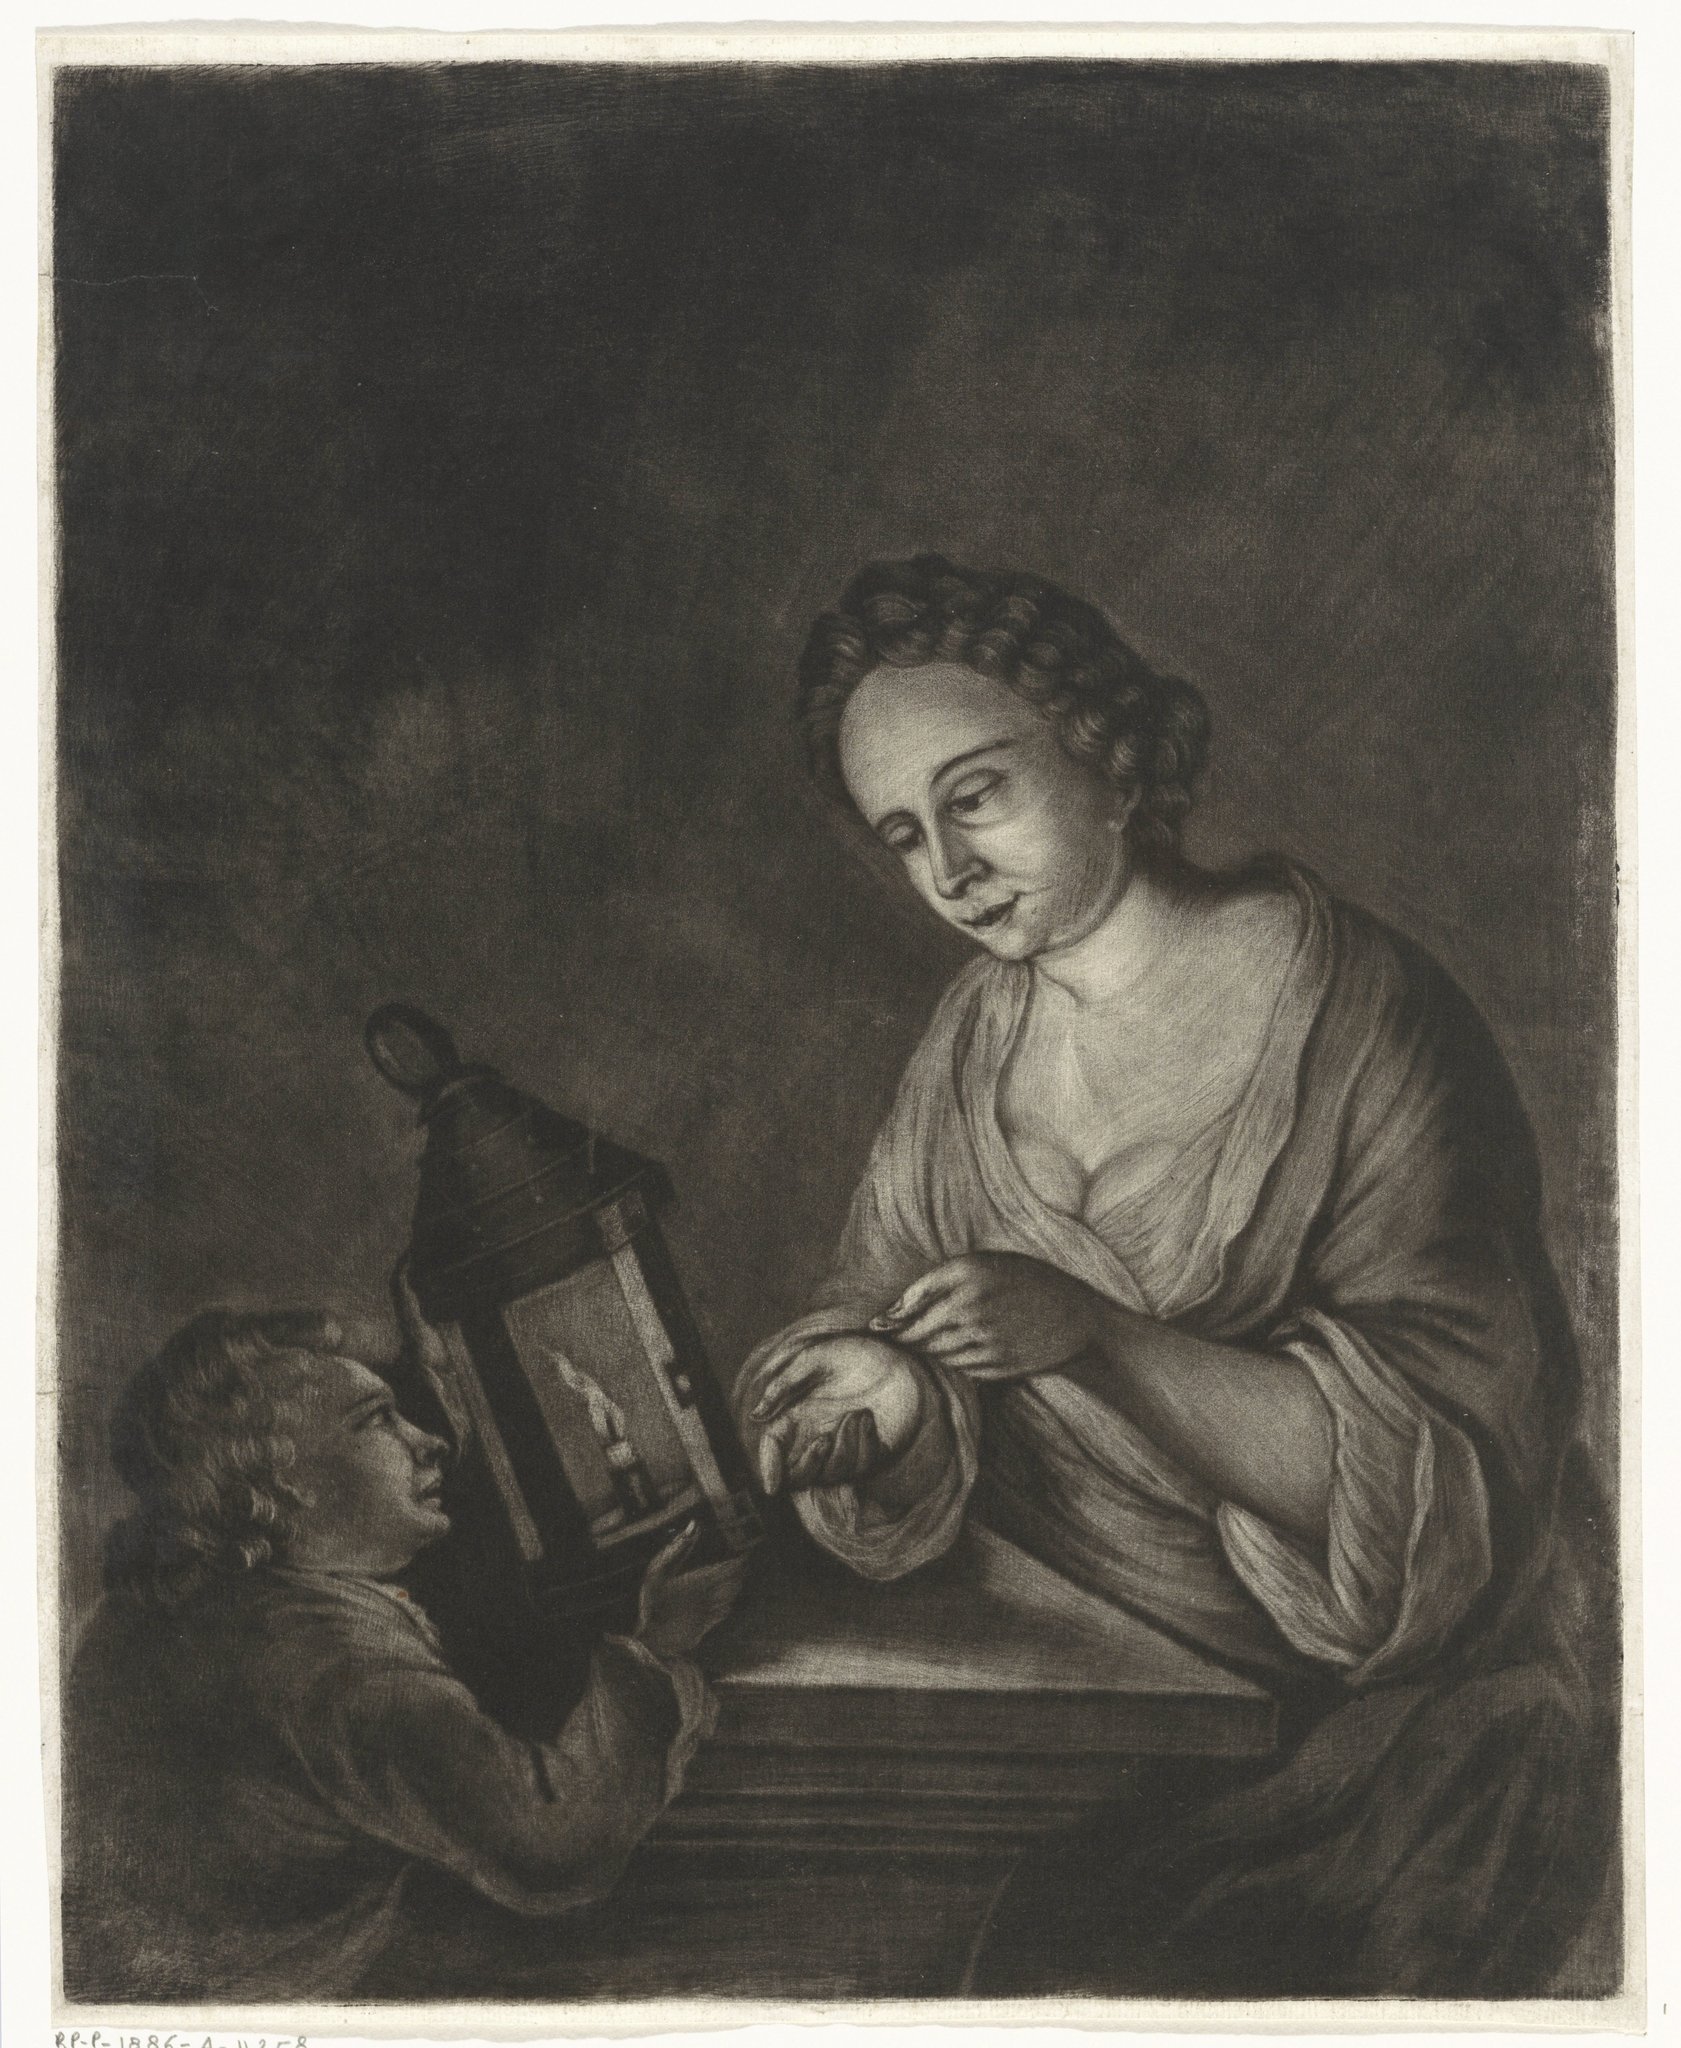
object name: print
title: Jongen ontvangt geld van een vrouw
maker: jacob hoolaart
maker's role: print maker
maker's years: 1713-1789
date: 1723-1789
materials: paper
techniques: mezzotint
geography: dordrecht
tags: coin, lantern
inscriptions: collector's mark: Lugt 2228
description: Een jongen met een lantaarn ontvangt geld van een vrouw. Hij reikt haar de lantaarn aan.